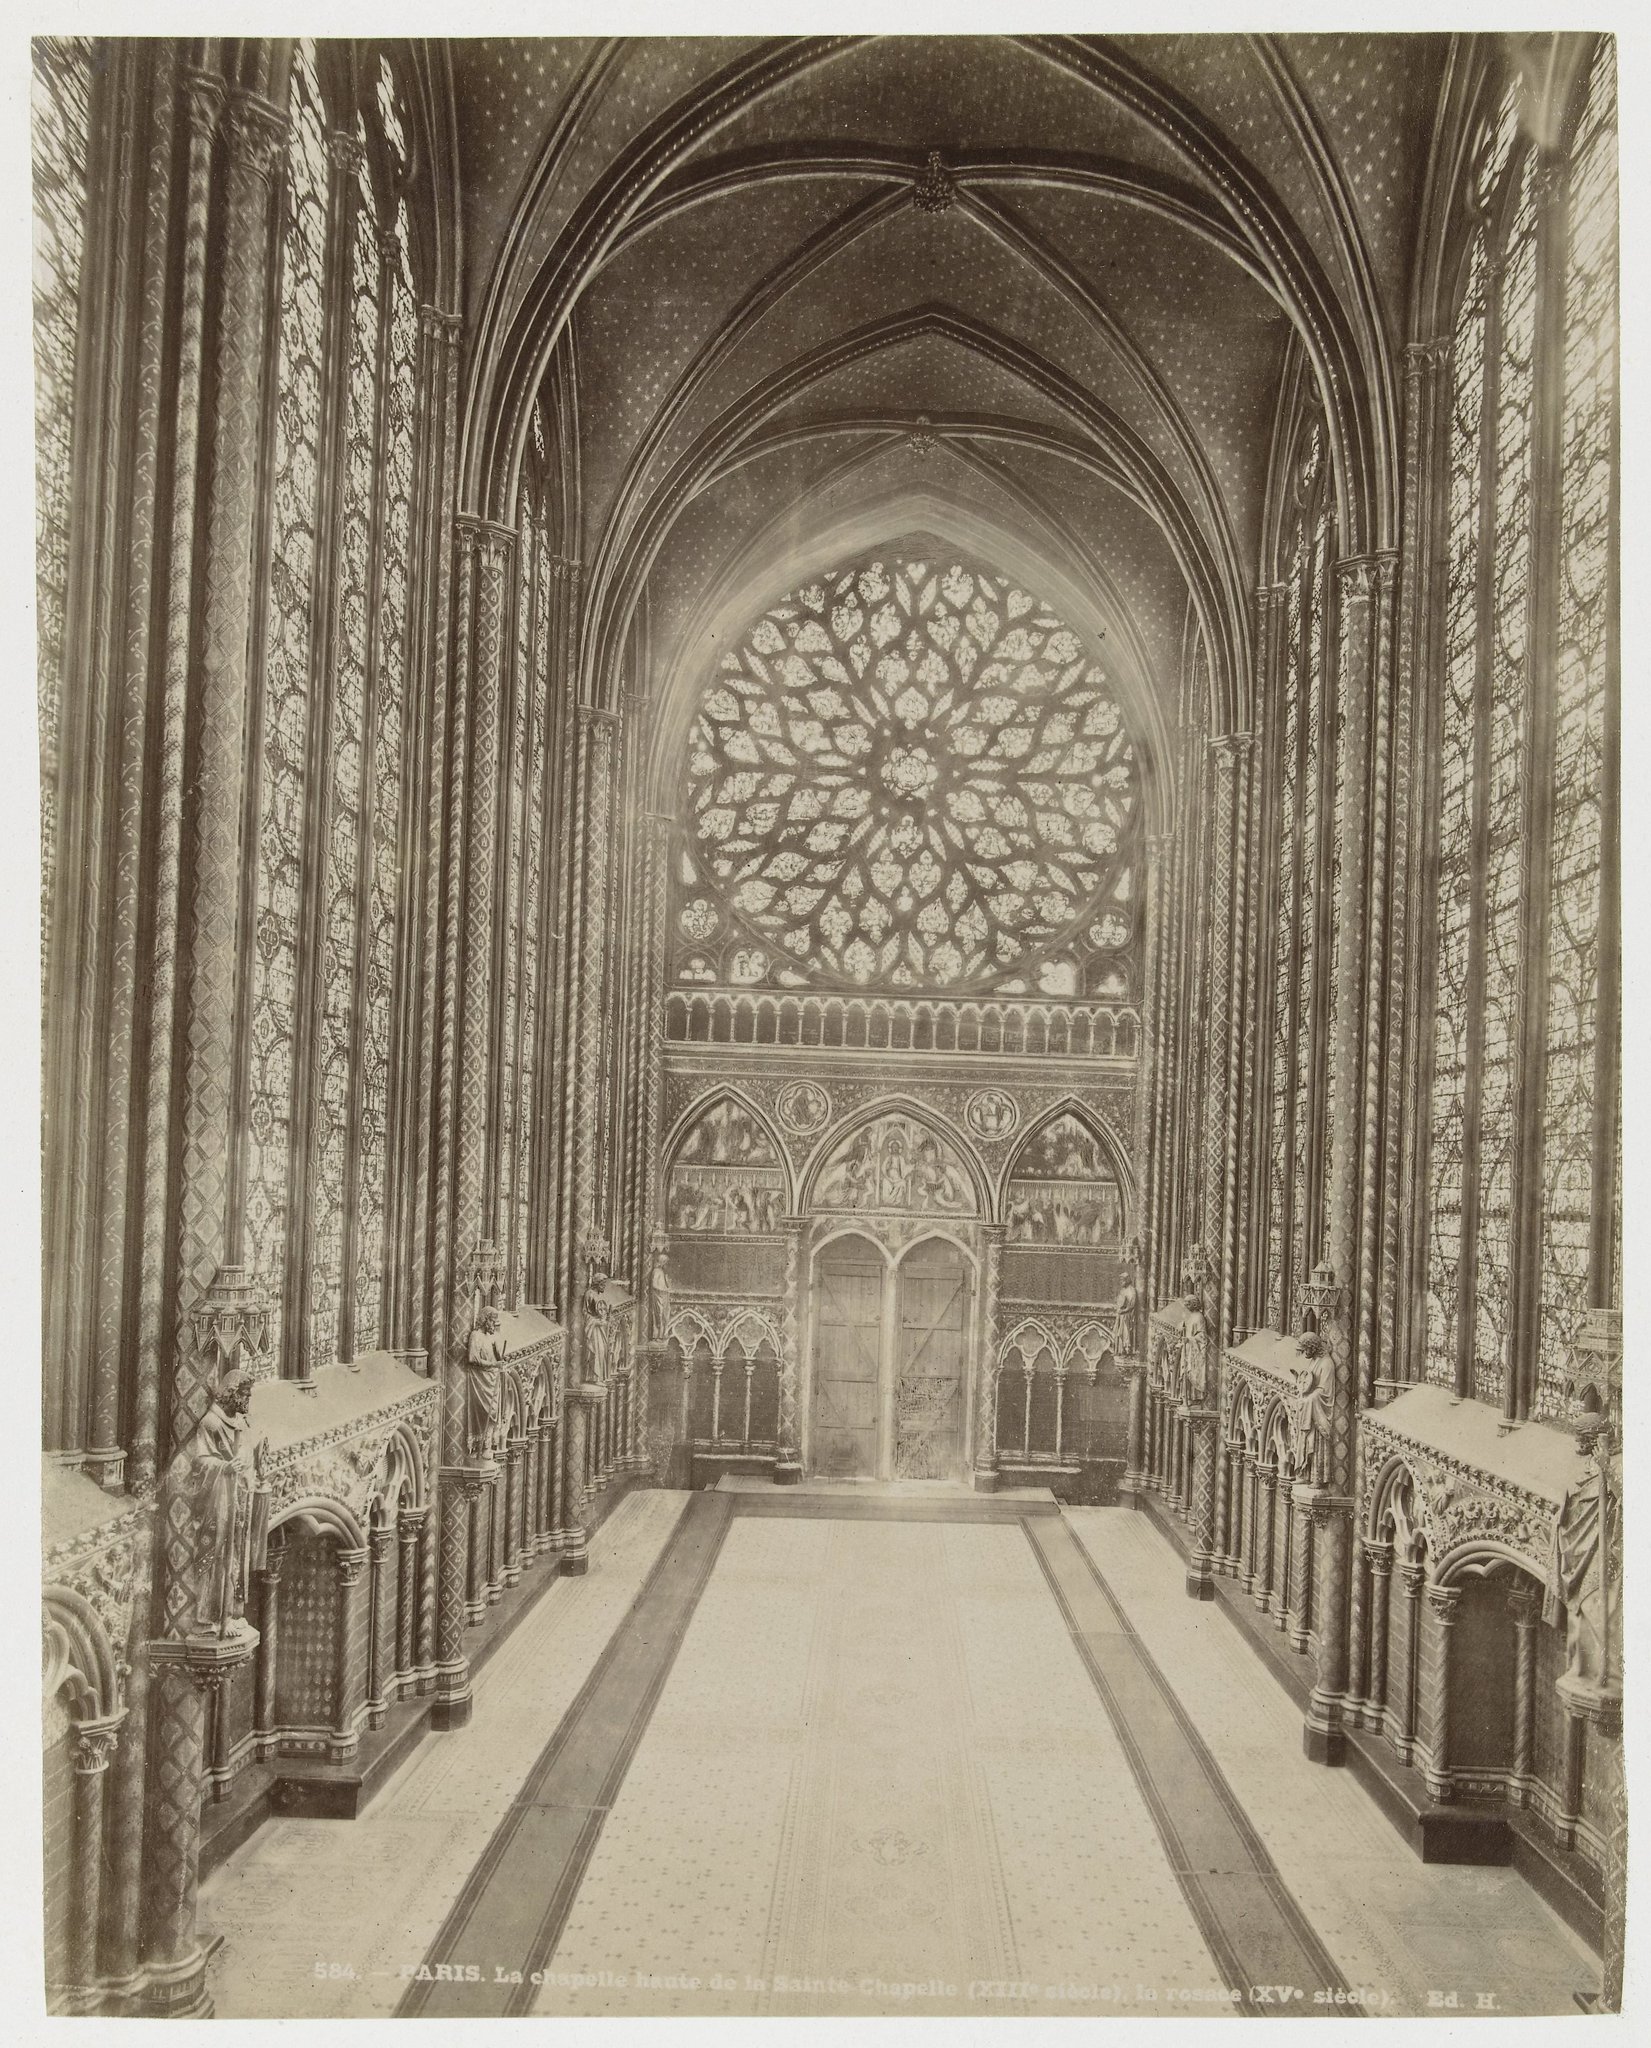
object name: photograph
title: Paris, la chapelle haute de la Sainte-Chapelle (XIIIe siècle), la rosace (XVe siècle) . Ed. H.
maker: edouard hautecoer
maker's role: publisher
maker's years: 1847-1904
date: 1870-1904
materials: cardboard, paper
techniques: albumen print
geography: paris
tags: parts of church interior: chapel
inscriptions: number: ‘584.’